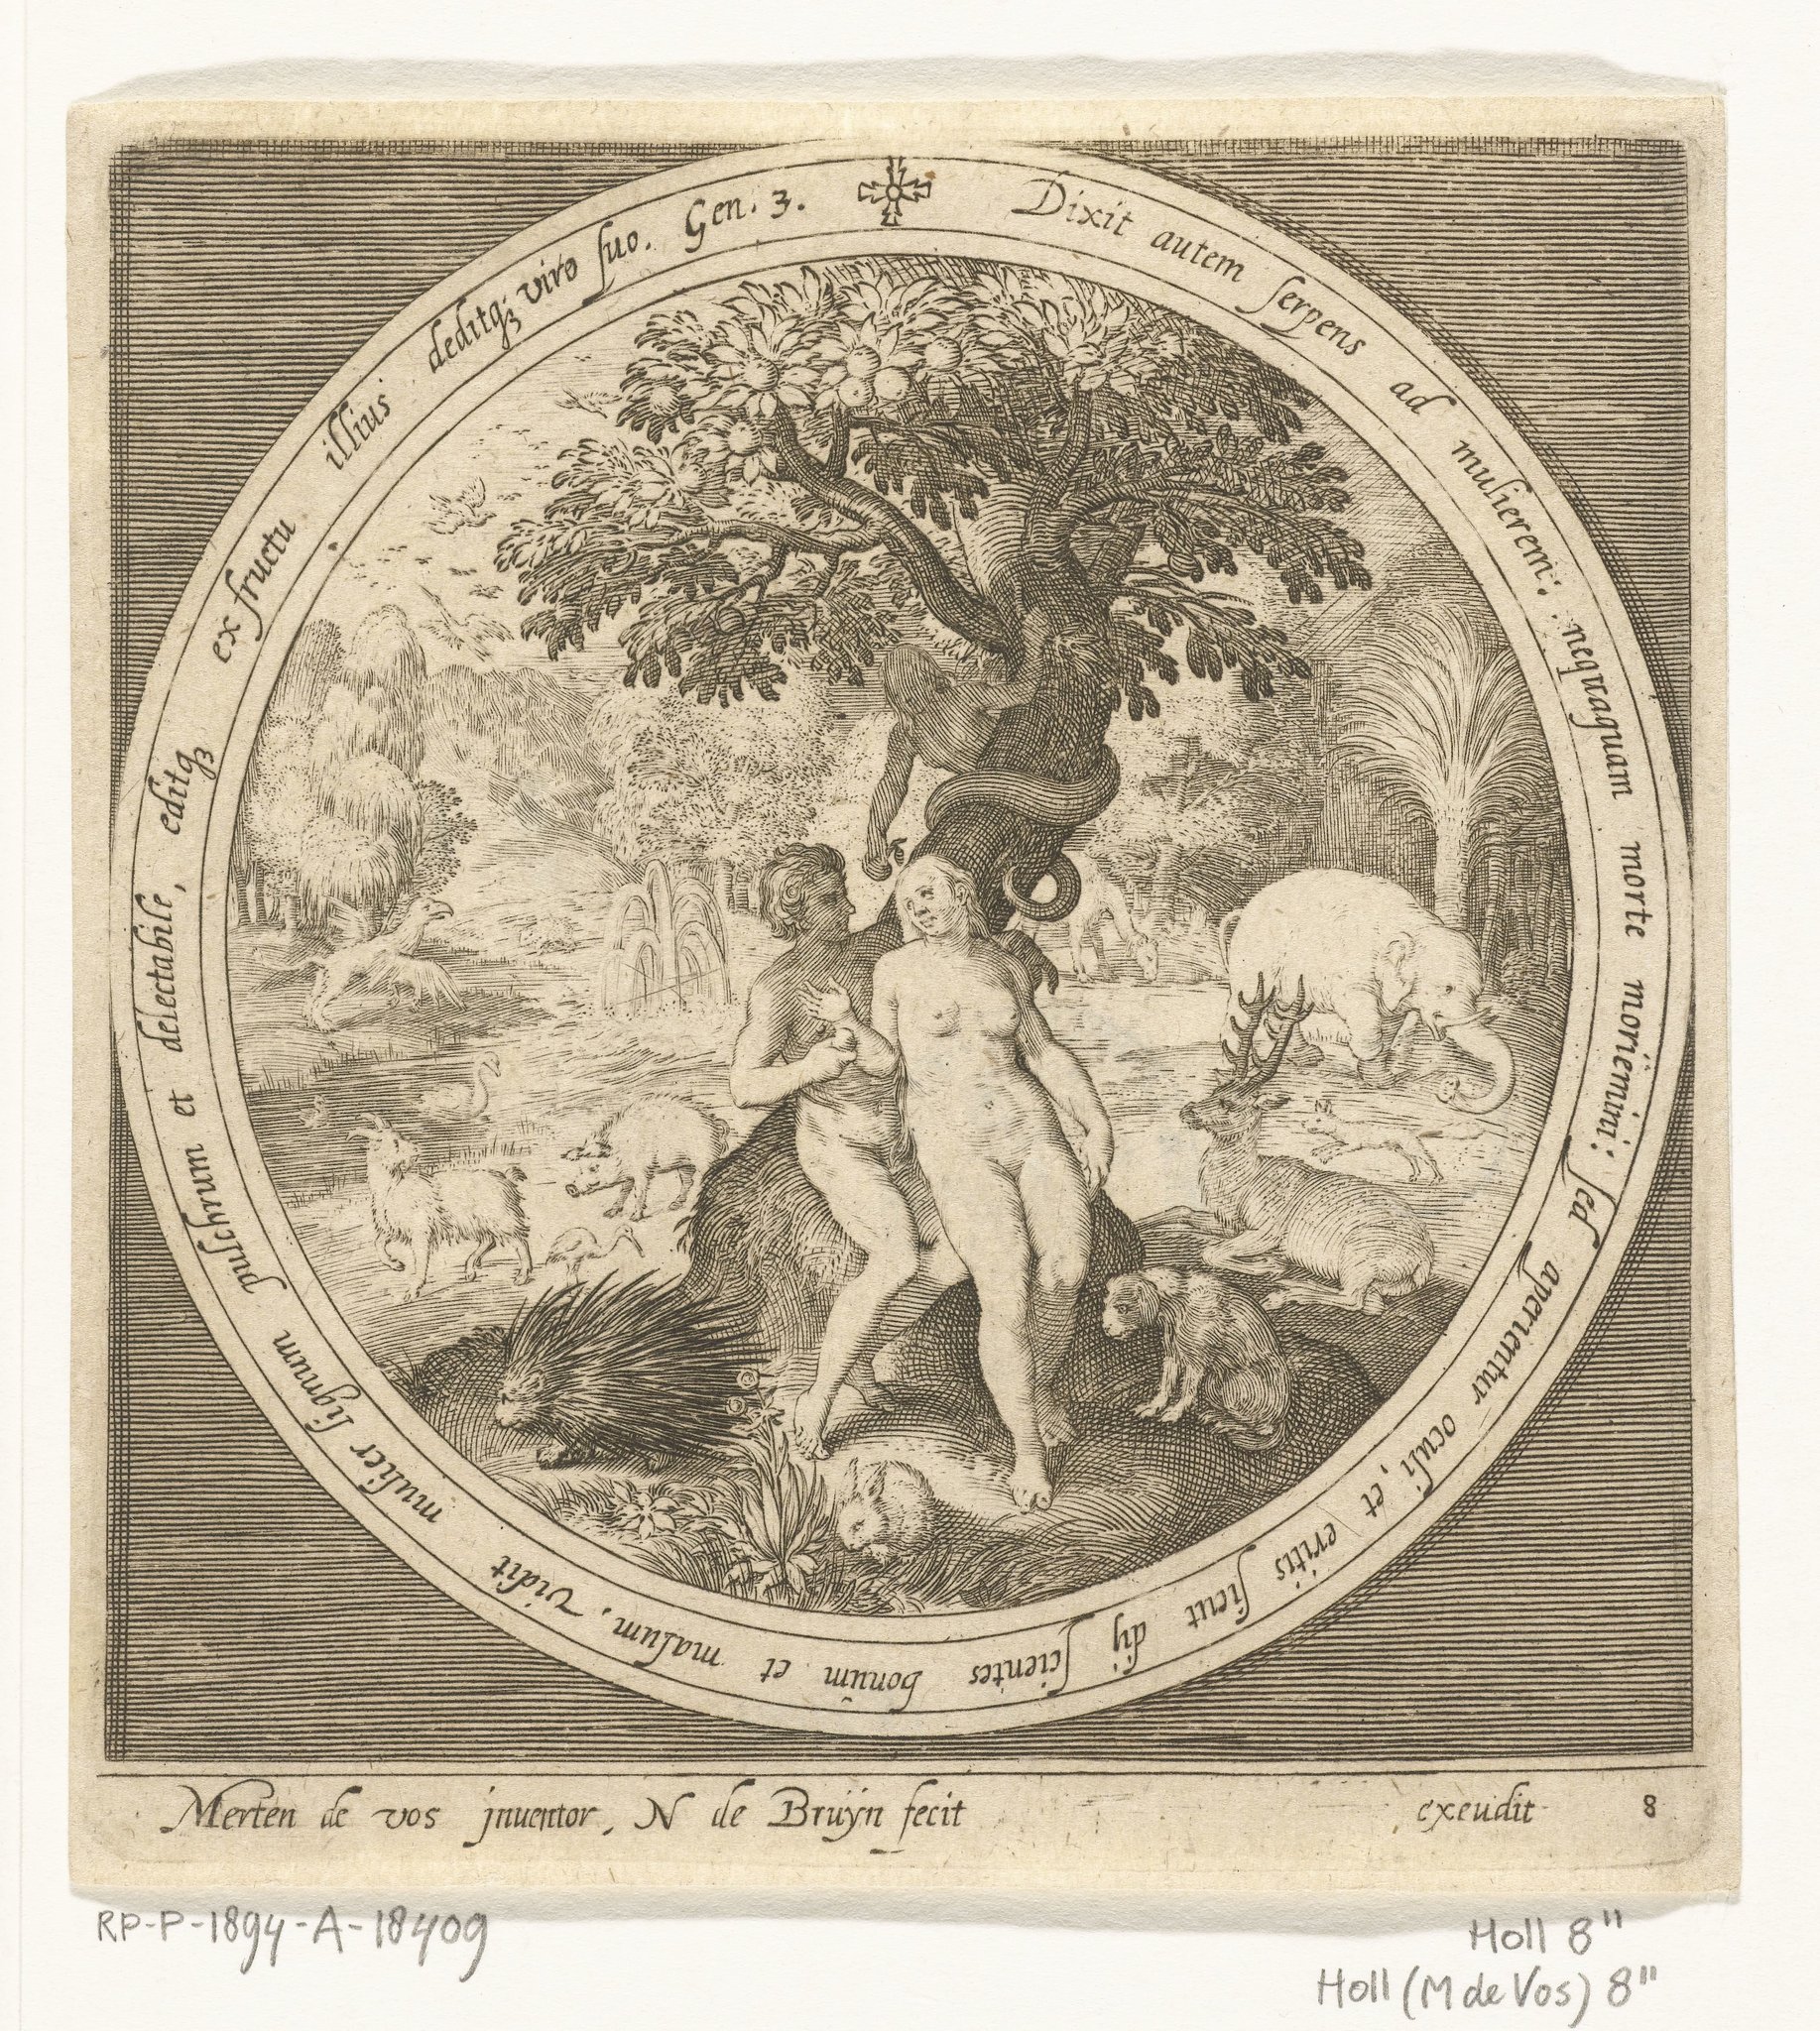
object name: print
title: Van schepping tot verdrijving uit paradijs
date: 1581-1656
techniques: engraving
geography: netherlands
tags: eve offers the fruit to adam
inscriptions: collector's mark: Lugt 2228, collector's mark: Lugt 2510, collector's mark: Lugt 1606, collector's mark: Lugt 2482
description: Eva wordt misleid door de slang bij boom der kennis van goed en kwaad. Zij eet van de verboden appels en biedt Adam ook een vrucht aan. In medaillon met als opschrift een bijbeltekst in Latijn uit Genesis 3 binnen rechthoekige omlijsting.